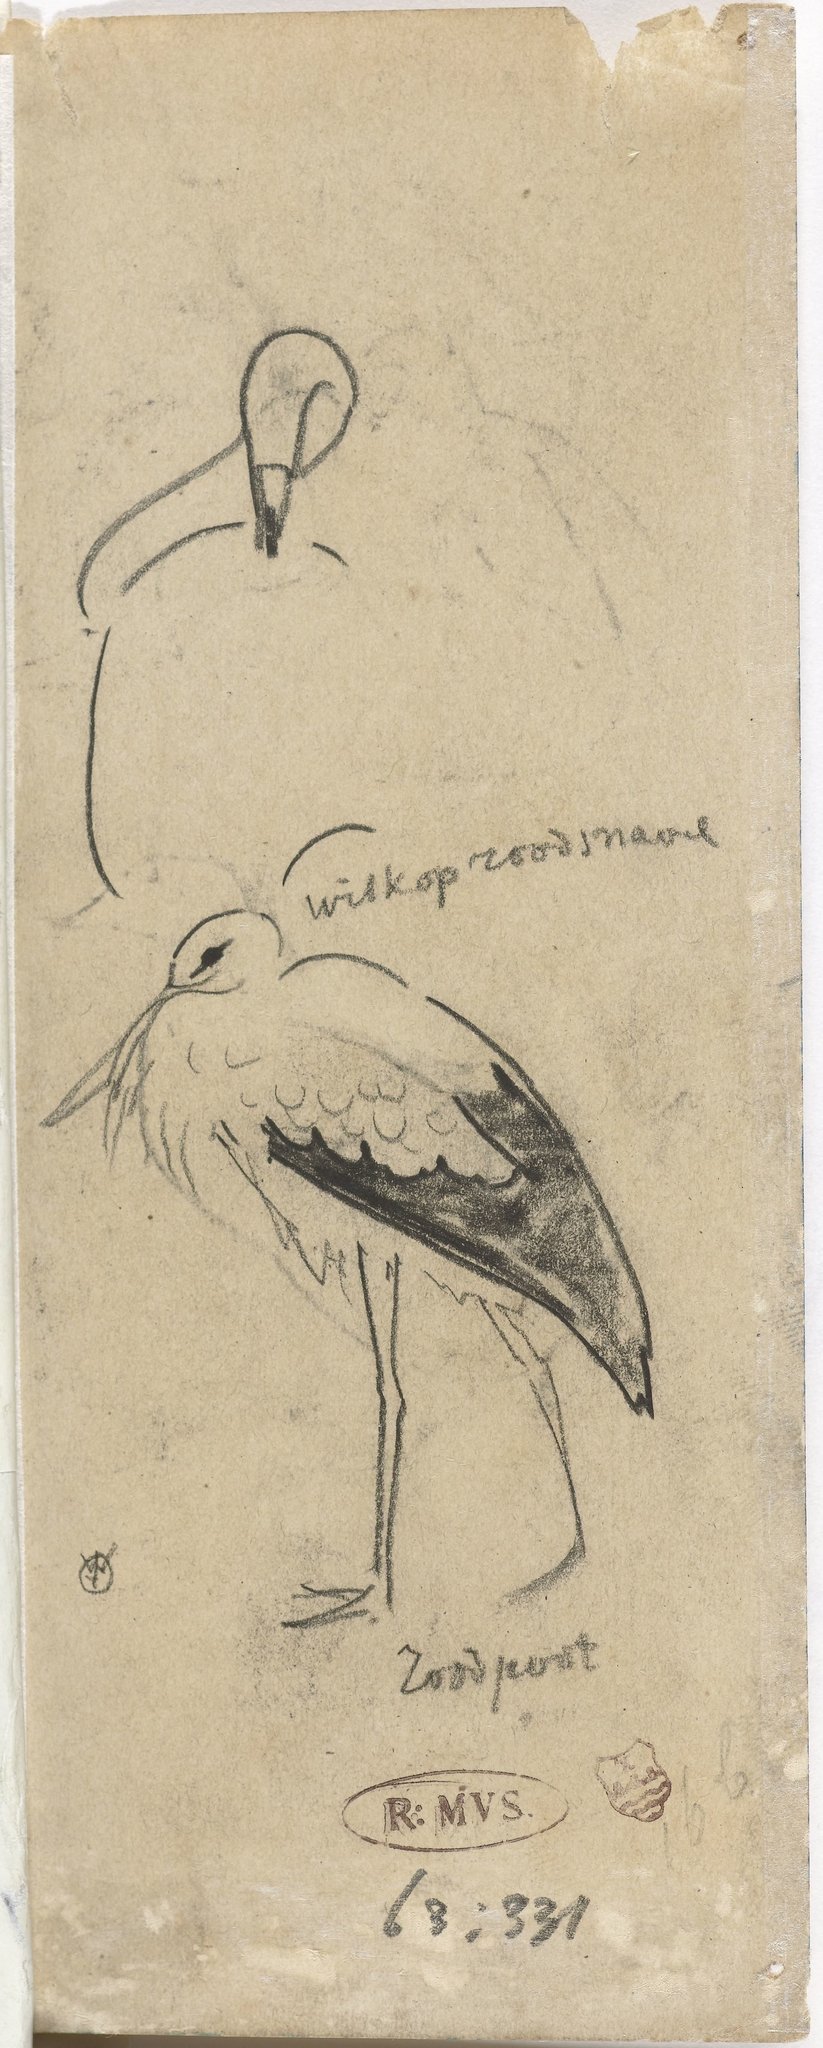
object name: drawing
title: Ooievaar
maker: gerrit willem dijsselhof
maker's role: designer, draughtsman, print maker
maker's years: 1866-1924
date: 1876-1924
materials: chalk, paper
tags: shore-birds and wading-birds: stork